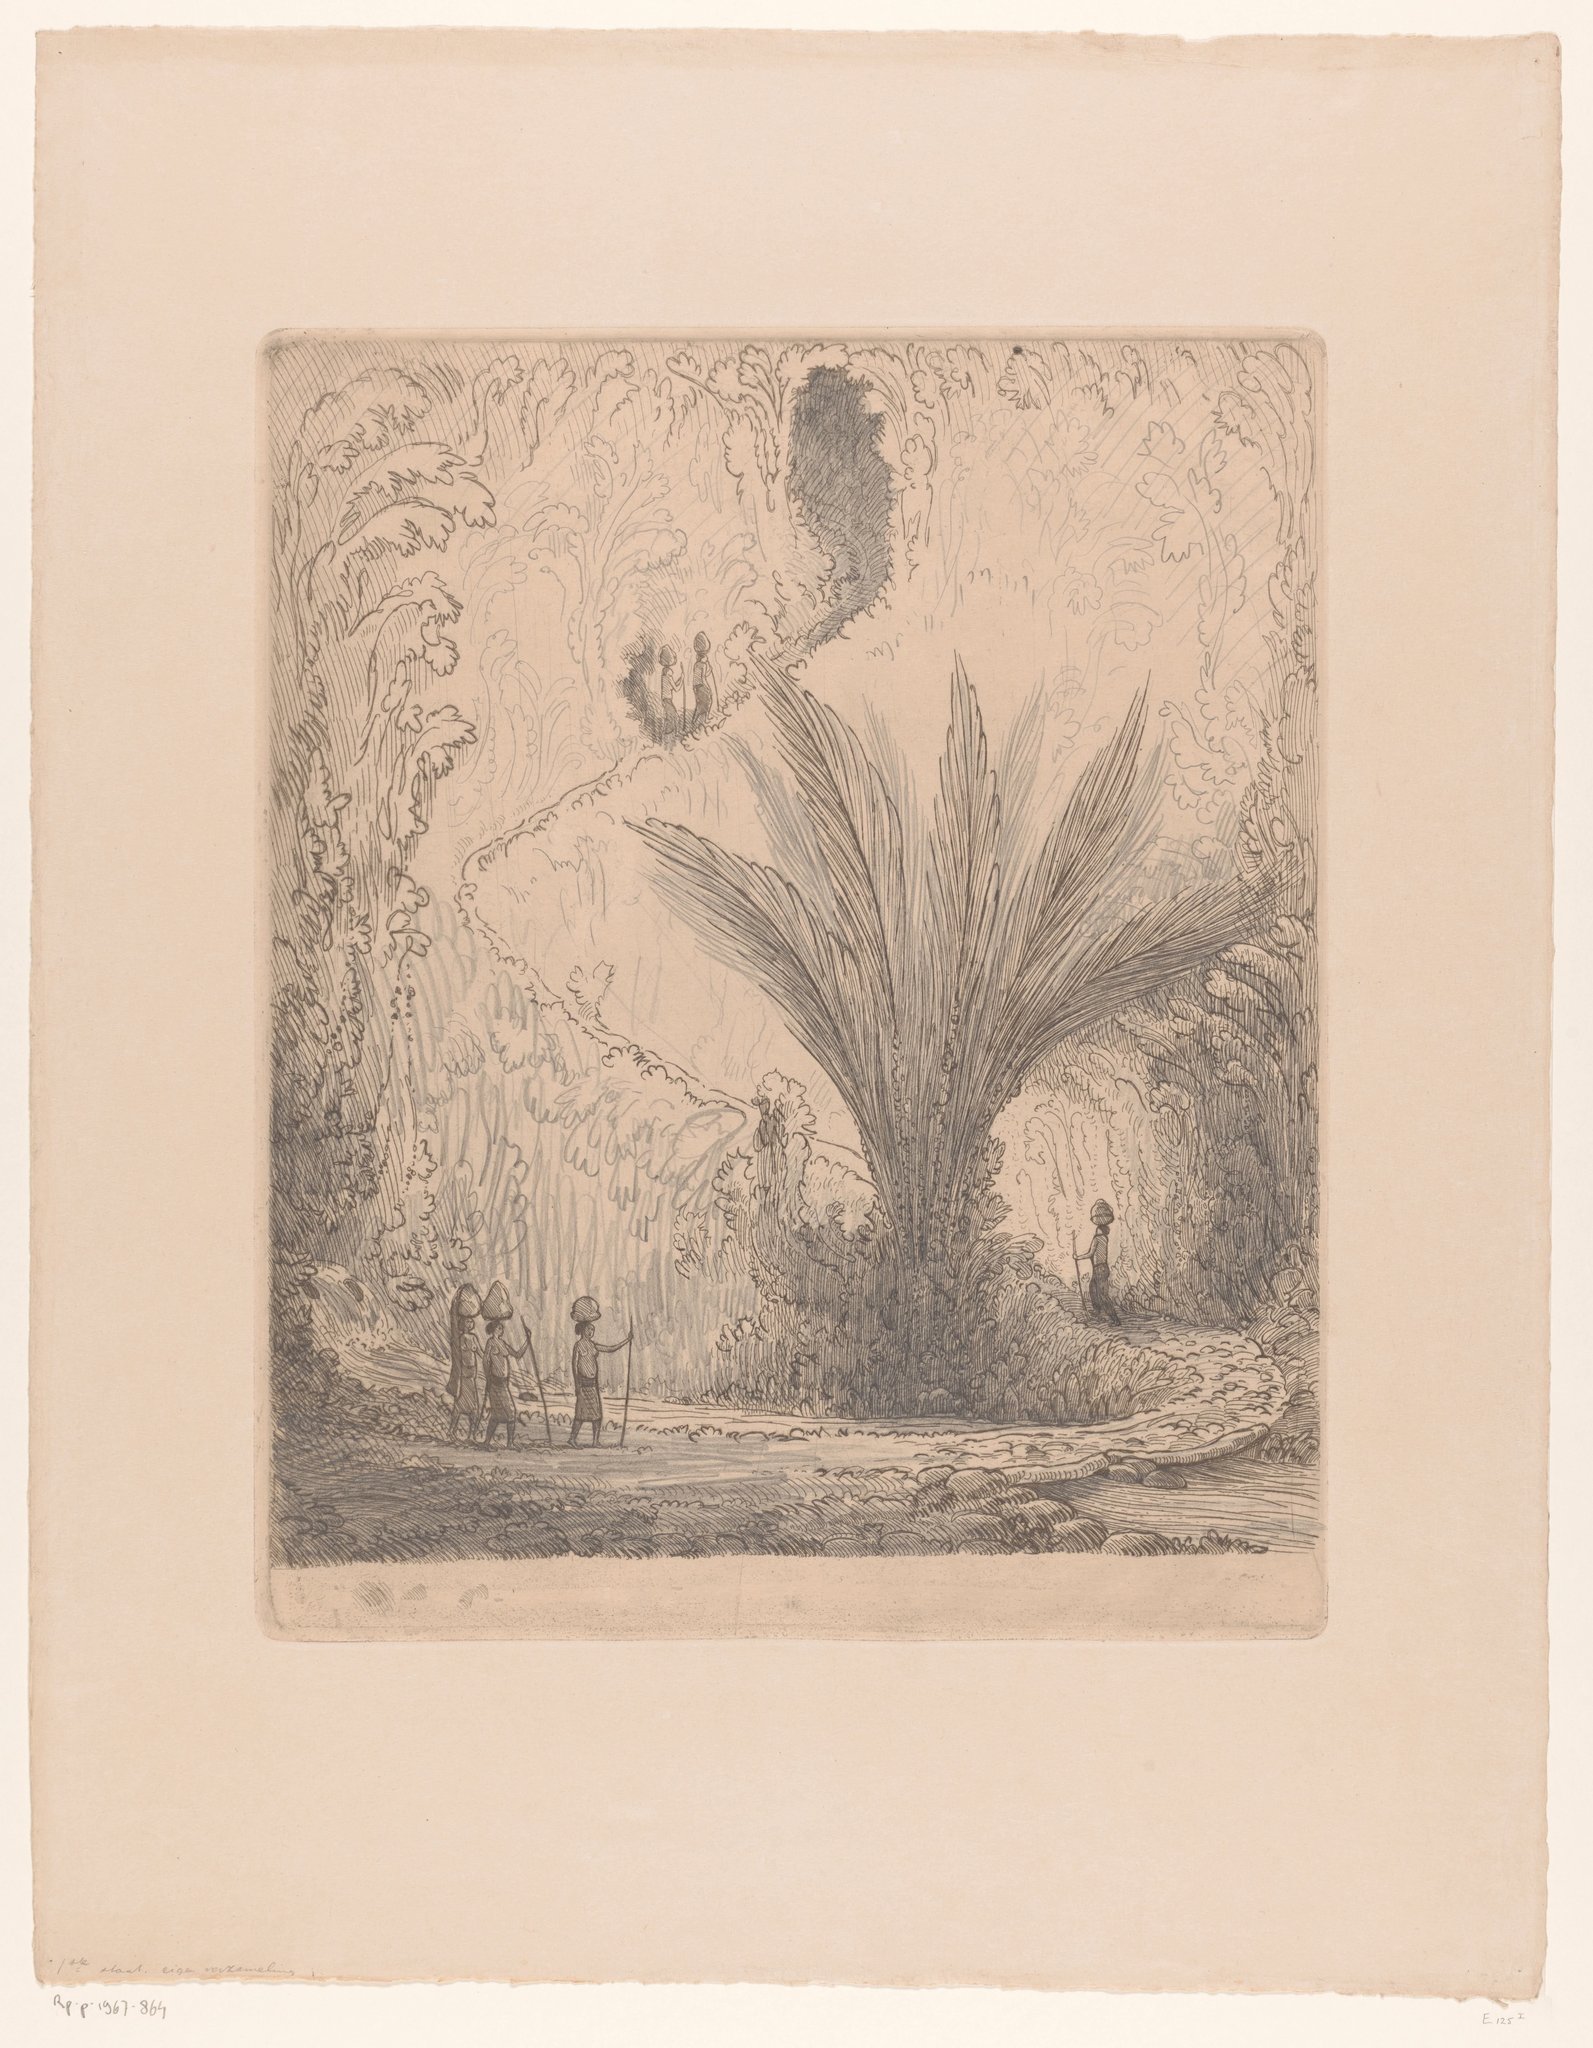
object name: print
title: Begroeide berghelling met vrouwen die goederen op hun hoofd dragen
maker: wijnand otto jan nieuwenkamp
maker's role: draughtsman, print maker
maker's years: 1874-1950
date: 1911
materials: paper, pencil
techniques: etching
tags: jungle, carrying something on the head or on the shoulders, mountains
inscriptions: collector's mark: Lugt 2228, collector's mark: Lugt 2760